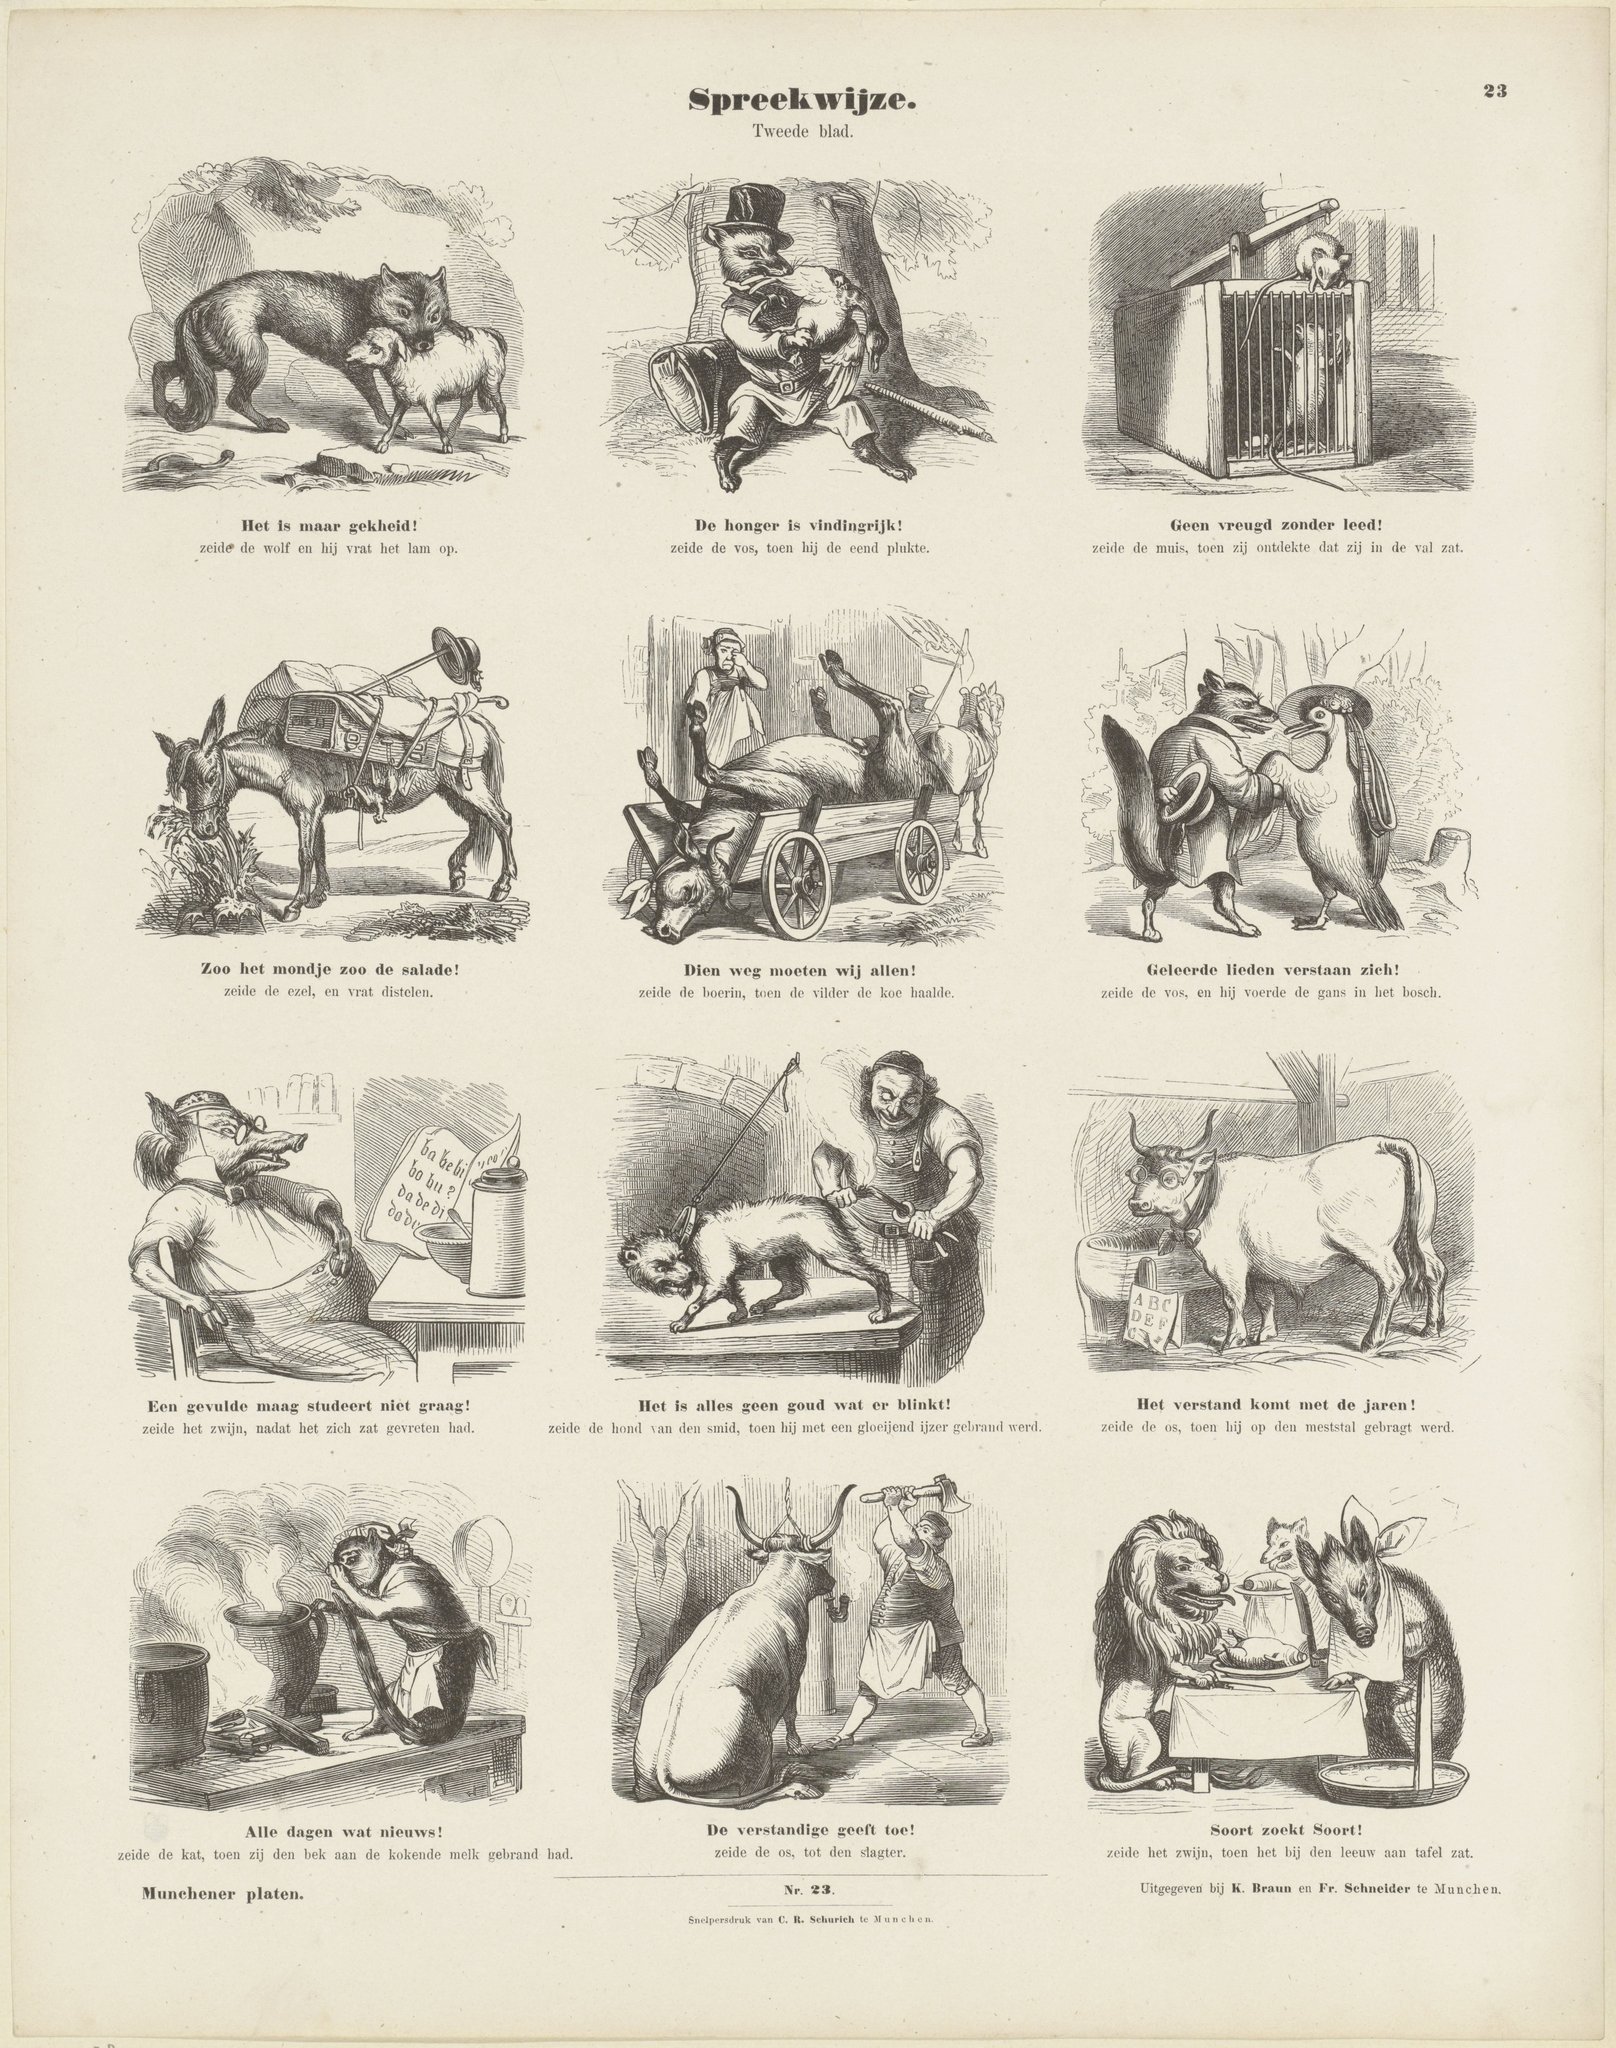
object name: print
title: Spreekwijze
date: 1843-1920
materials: paper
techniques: letterpress printing, engraving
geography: munich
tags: animals, animals acting as human beings, proverbs, sayings, etc.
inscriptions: collector's mark: Lugt 2760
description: Blad met 12 verbeeldingen van spreekwoorden door komische taferelen met dieren. Onder elke afbeelding een onderschrift. Genummerd midden onder: Nr. 23. Genummerd rechtsboven: 23.